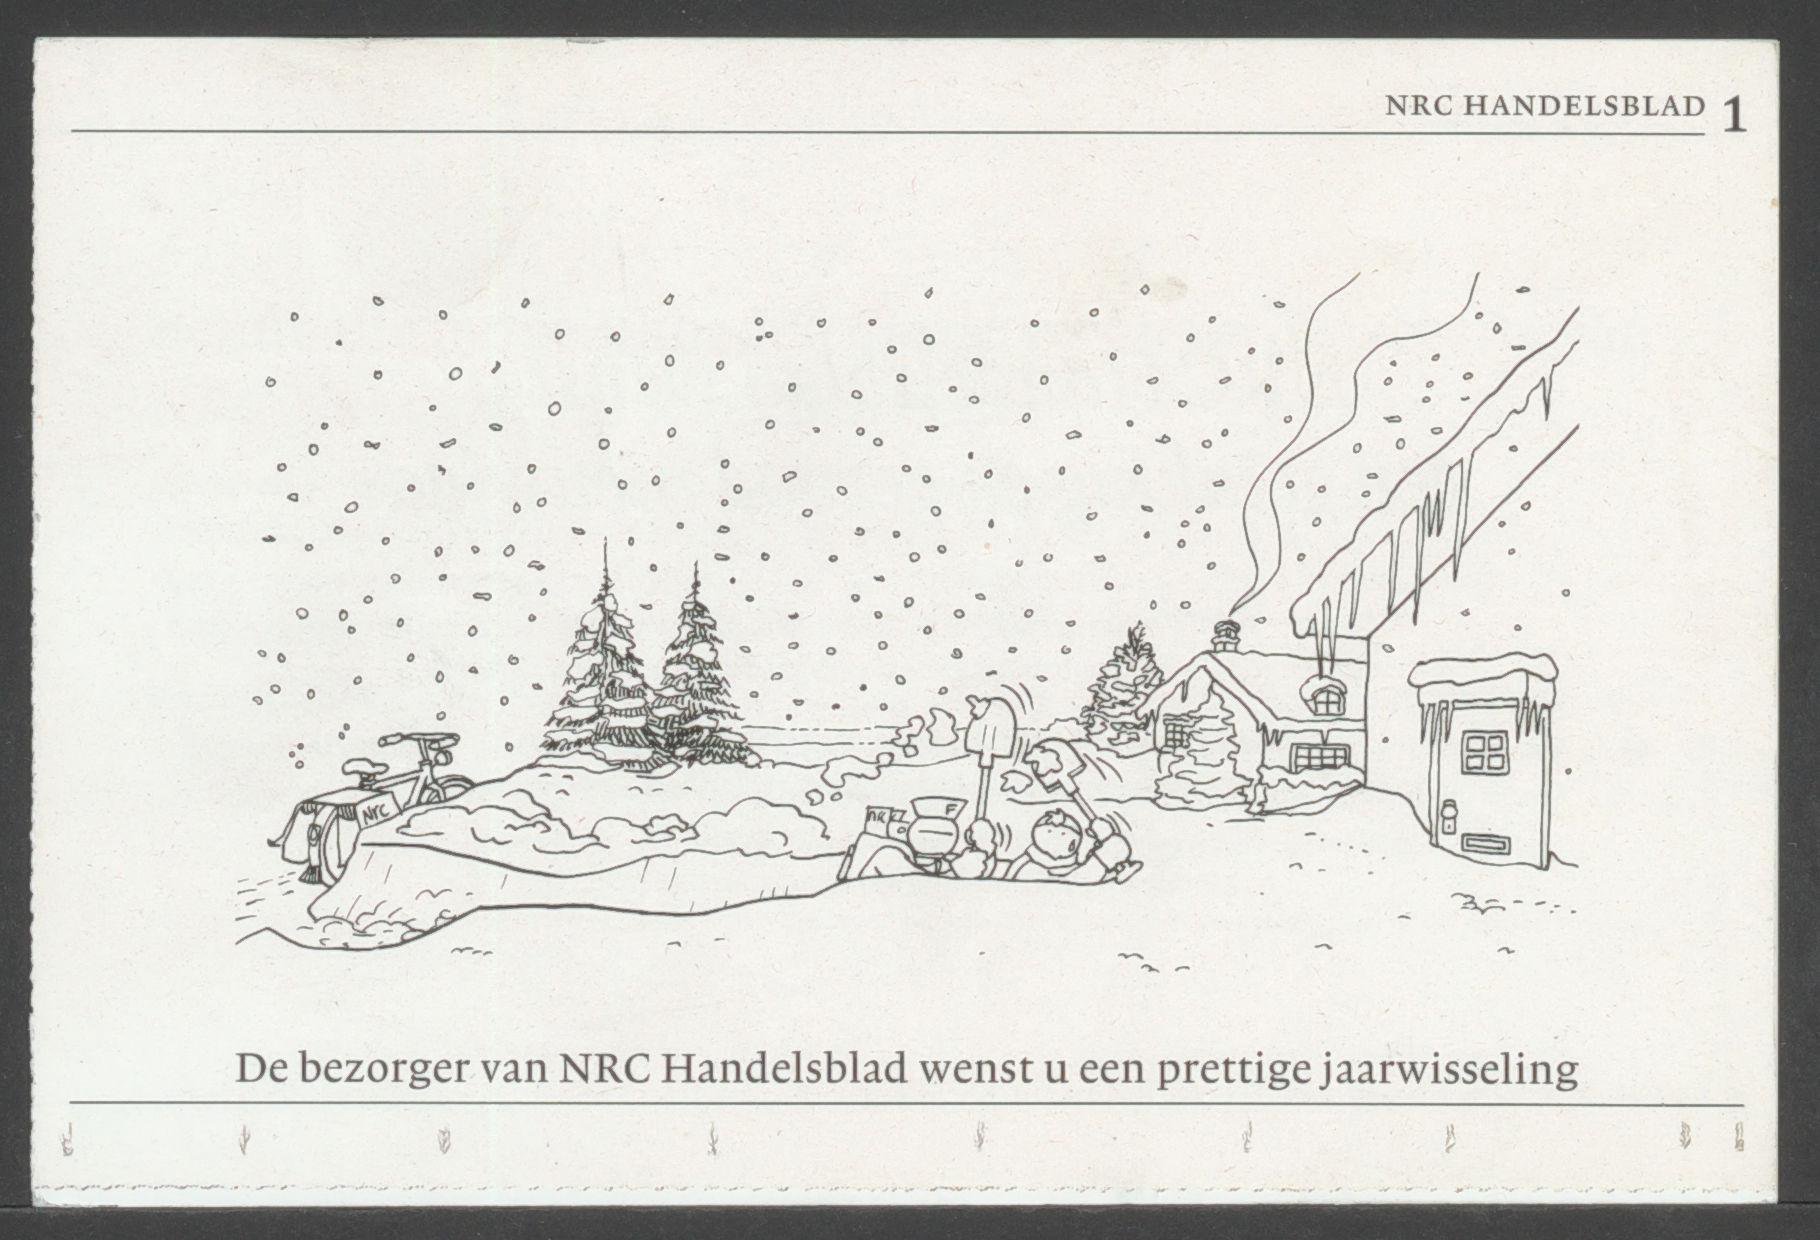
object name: photomechanical print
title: Nieuwjaarswens van de bezorger van NRC Handelsblad voor 2006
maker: Anonymous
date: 2005-2006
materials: paper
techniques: offset printed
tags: delivery (of newspaper), calendar, almanac, newspaper, news-sheet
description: Nieuwjaarswens van de bezorger van NRC Handelsblad. Met een cartoon waarin Fokke en Sukke door de sneeuw een krant proberen te bezorgen. Onderwerpsrubrieken binnen de Atlas Zeden en Gewoonten: Zeden en gewoonten in engeren zin, Volksleven, Volksbladen, Nieuwjaars- en Kerstwenschen.